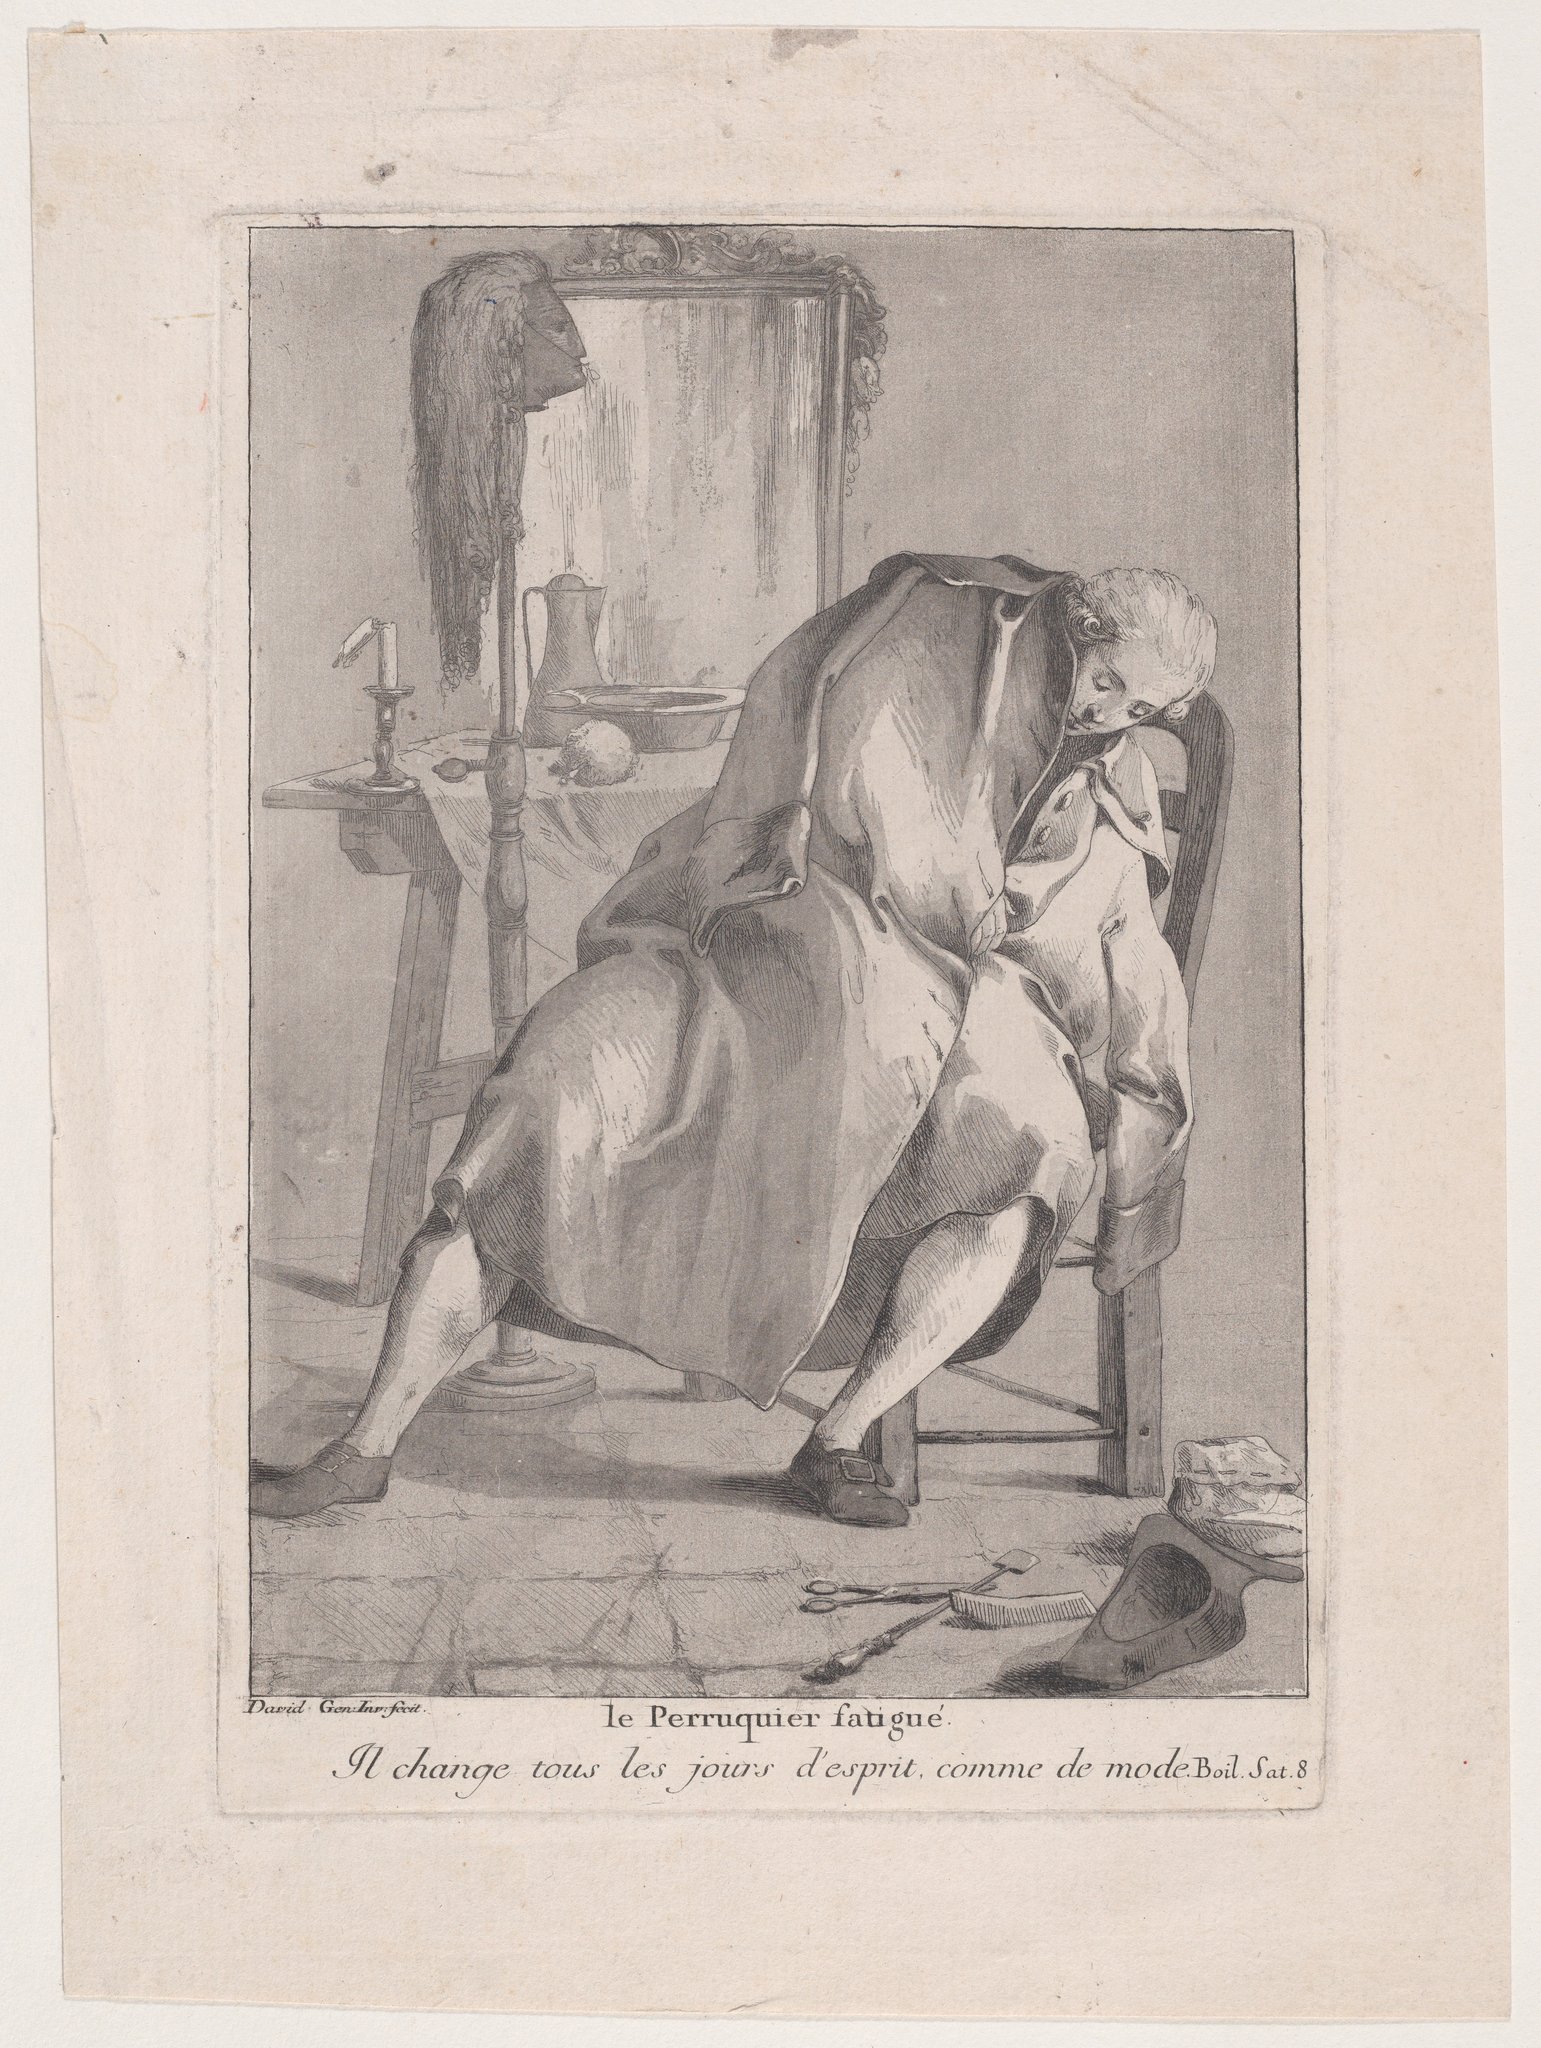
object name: print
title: The Tired Wigmaker, from "Divers Portraits"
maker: giovanni david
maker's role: artist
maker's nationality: italian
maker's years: 1749-1790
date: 1775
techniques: aquatint, etching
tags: sleeping,men